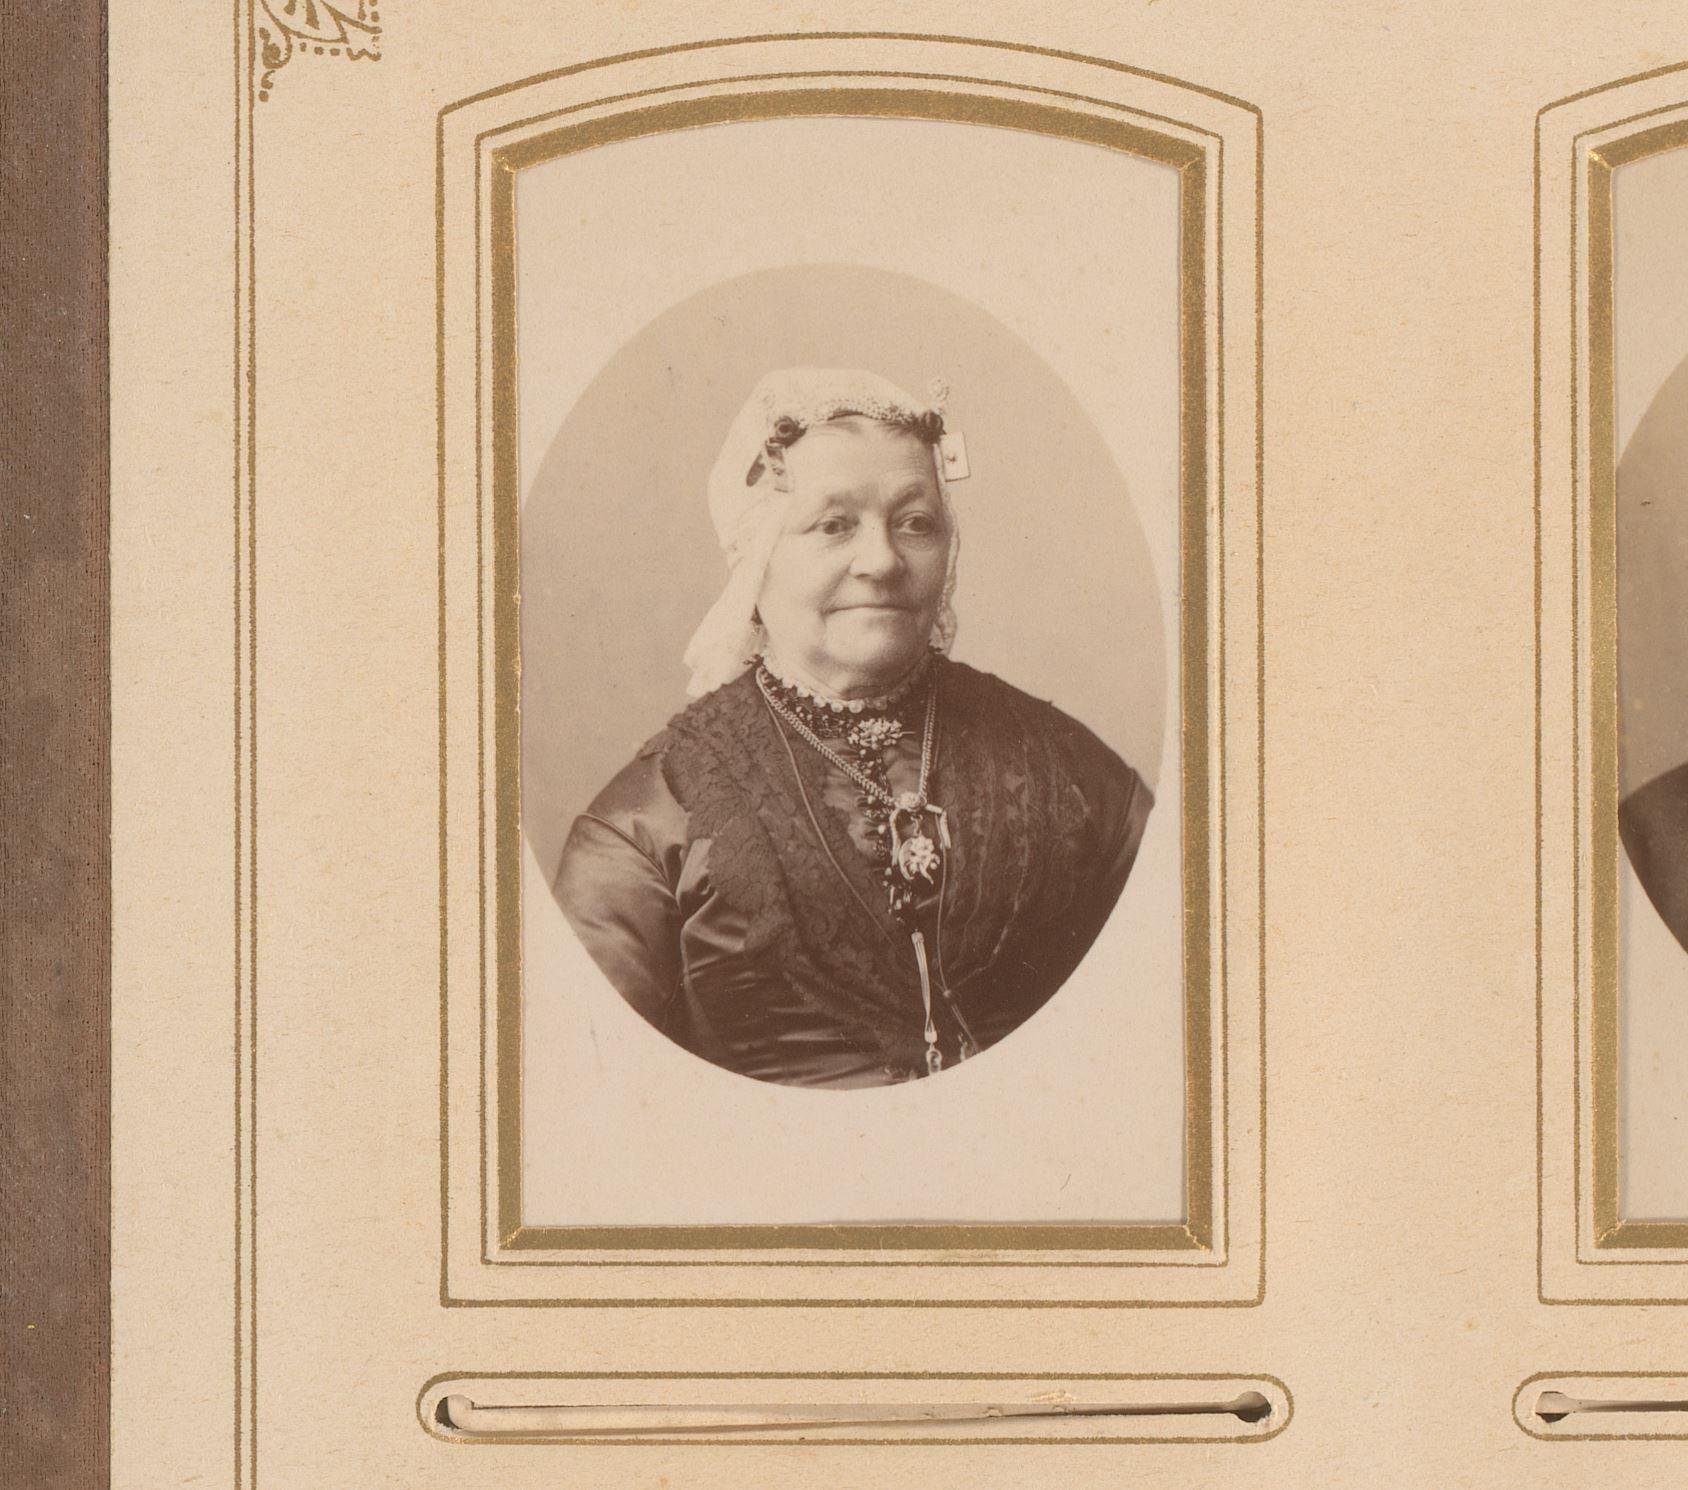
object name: carte de visite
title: Portret van een vrouw met klederdrachtmuts en oorijzers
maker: albert greiner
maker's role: fotograaf, fotostudio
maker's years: 1833-1890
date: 1883-1887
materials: cardboard, photographic support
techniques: albumen print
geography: amsterdam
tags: historical persons - bb - woman, head-gear: cap, folk costume, regional costume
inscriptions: inscription: ‘ALBERT GREINER/ KON. NED. HOF-PHOTOGRAAF/ AMSTERDAM/ NIEUWENDIJK 89./ Specialiteit in Vergrootingen.’